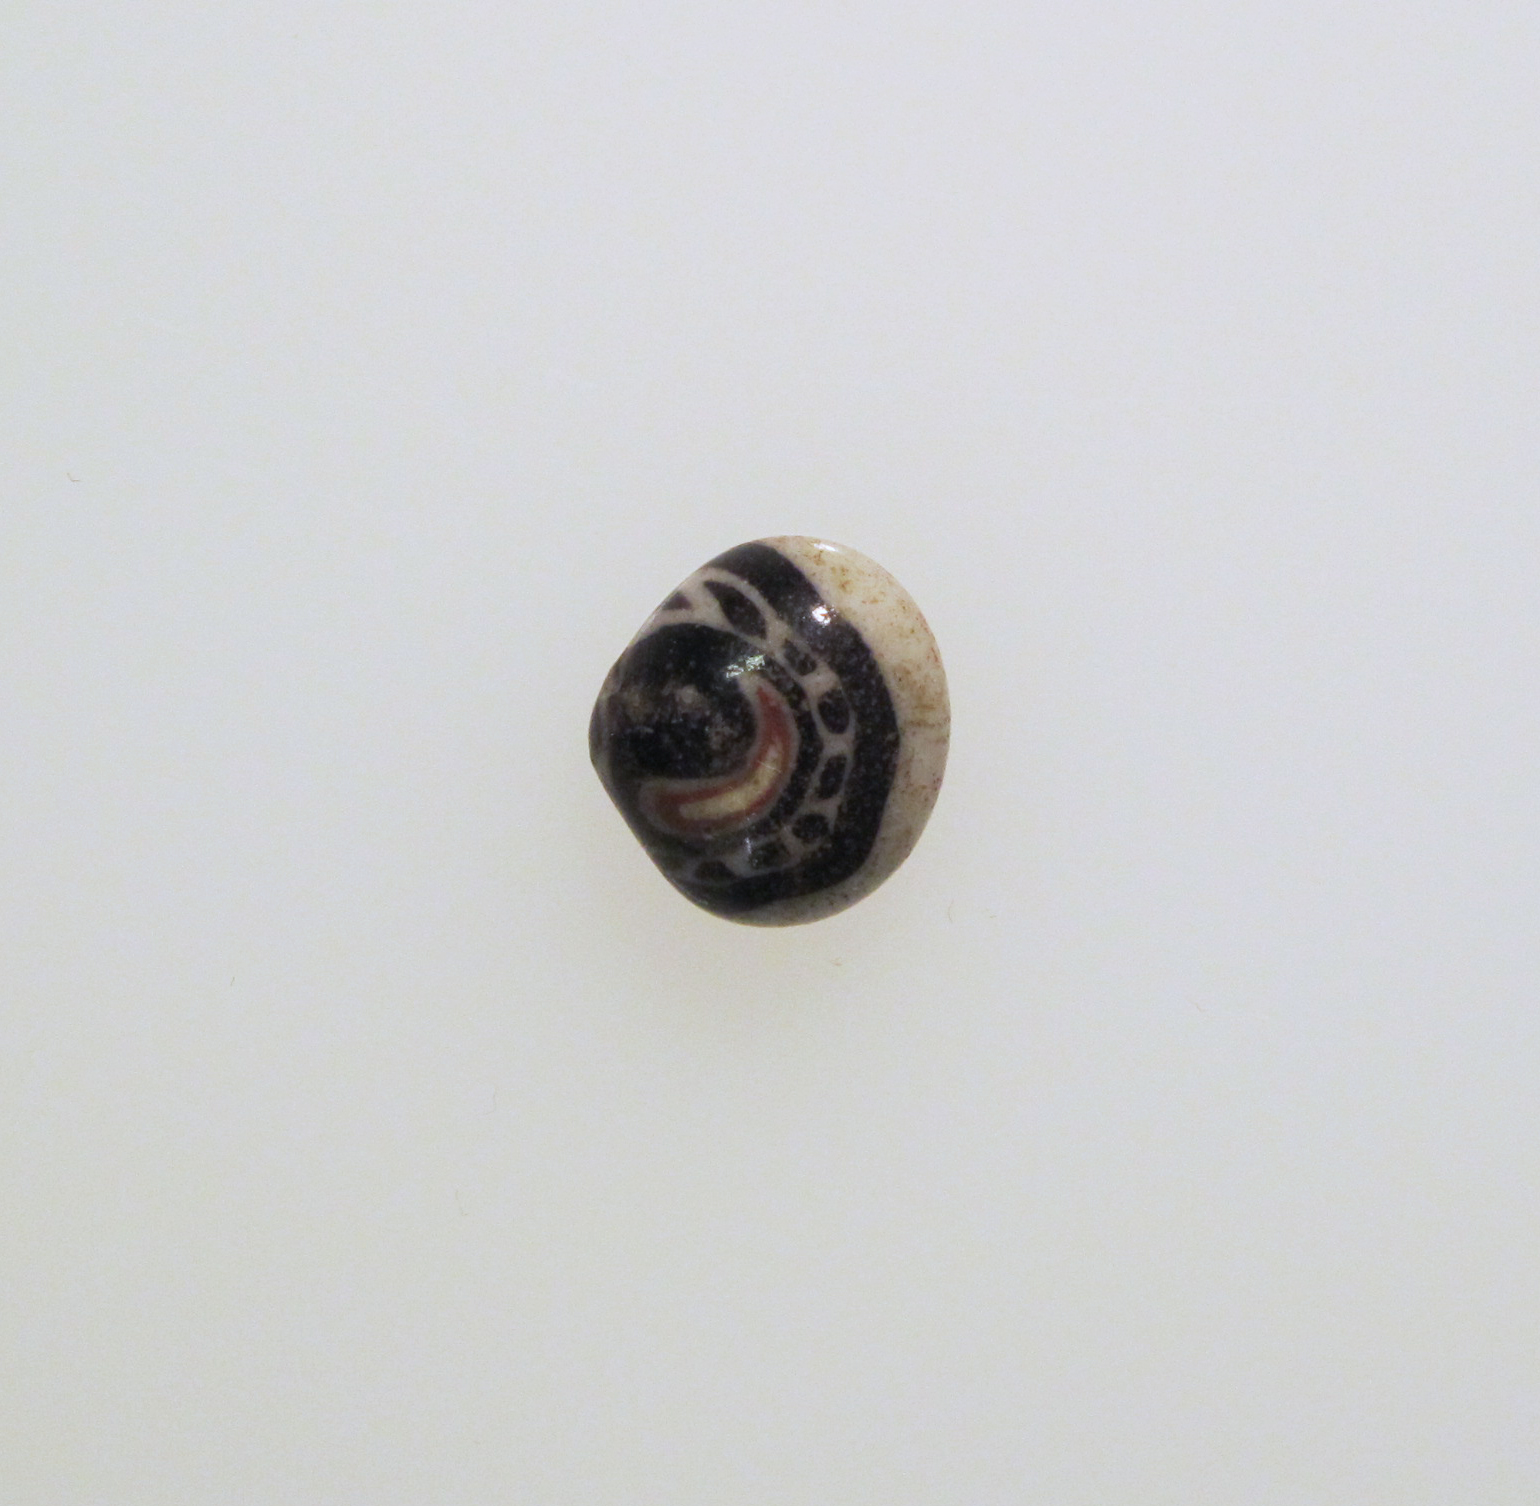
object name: pinhead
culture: roman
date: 670 BCE-330 CE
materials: glass